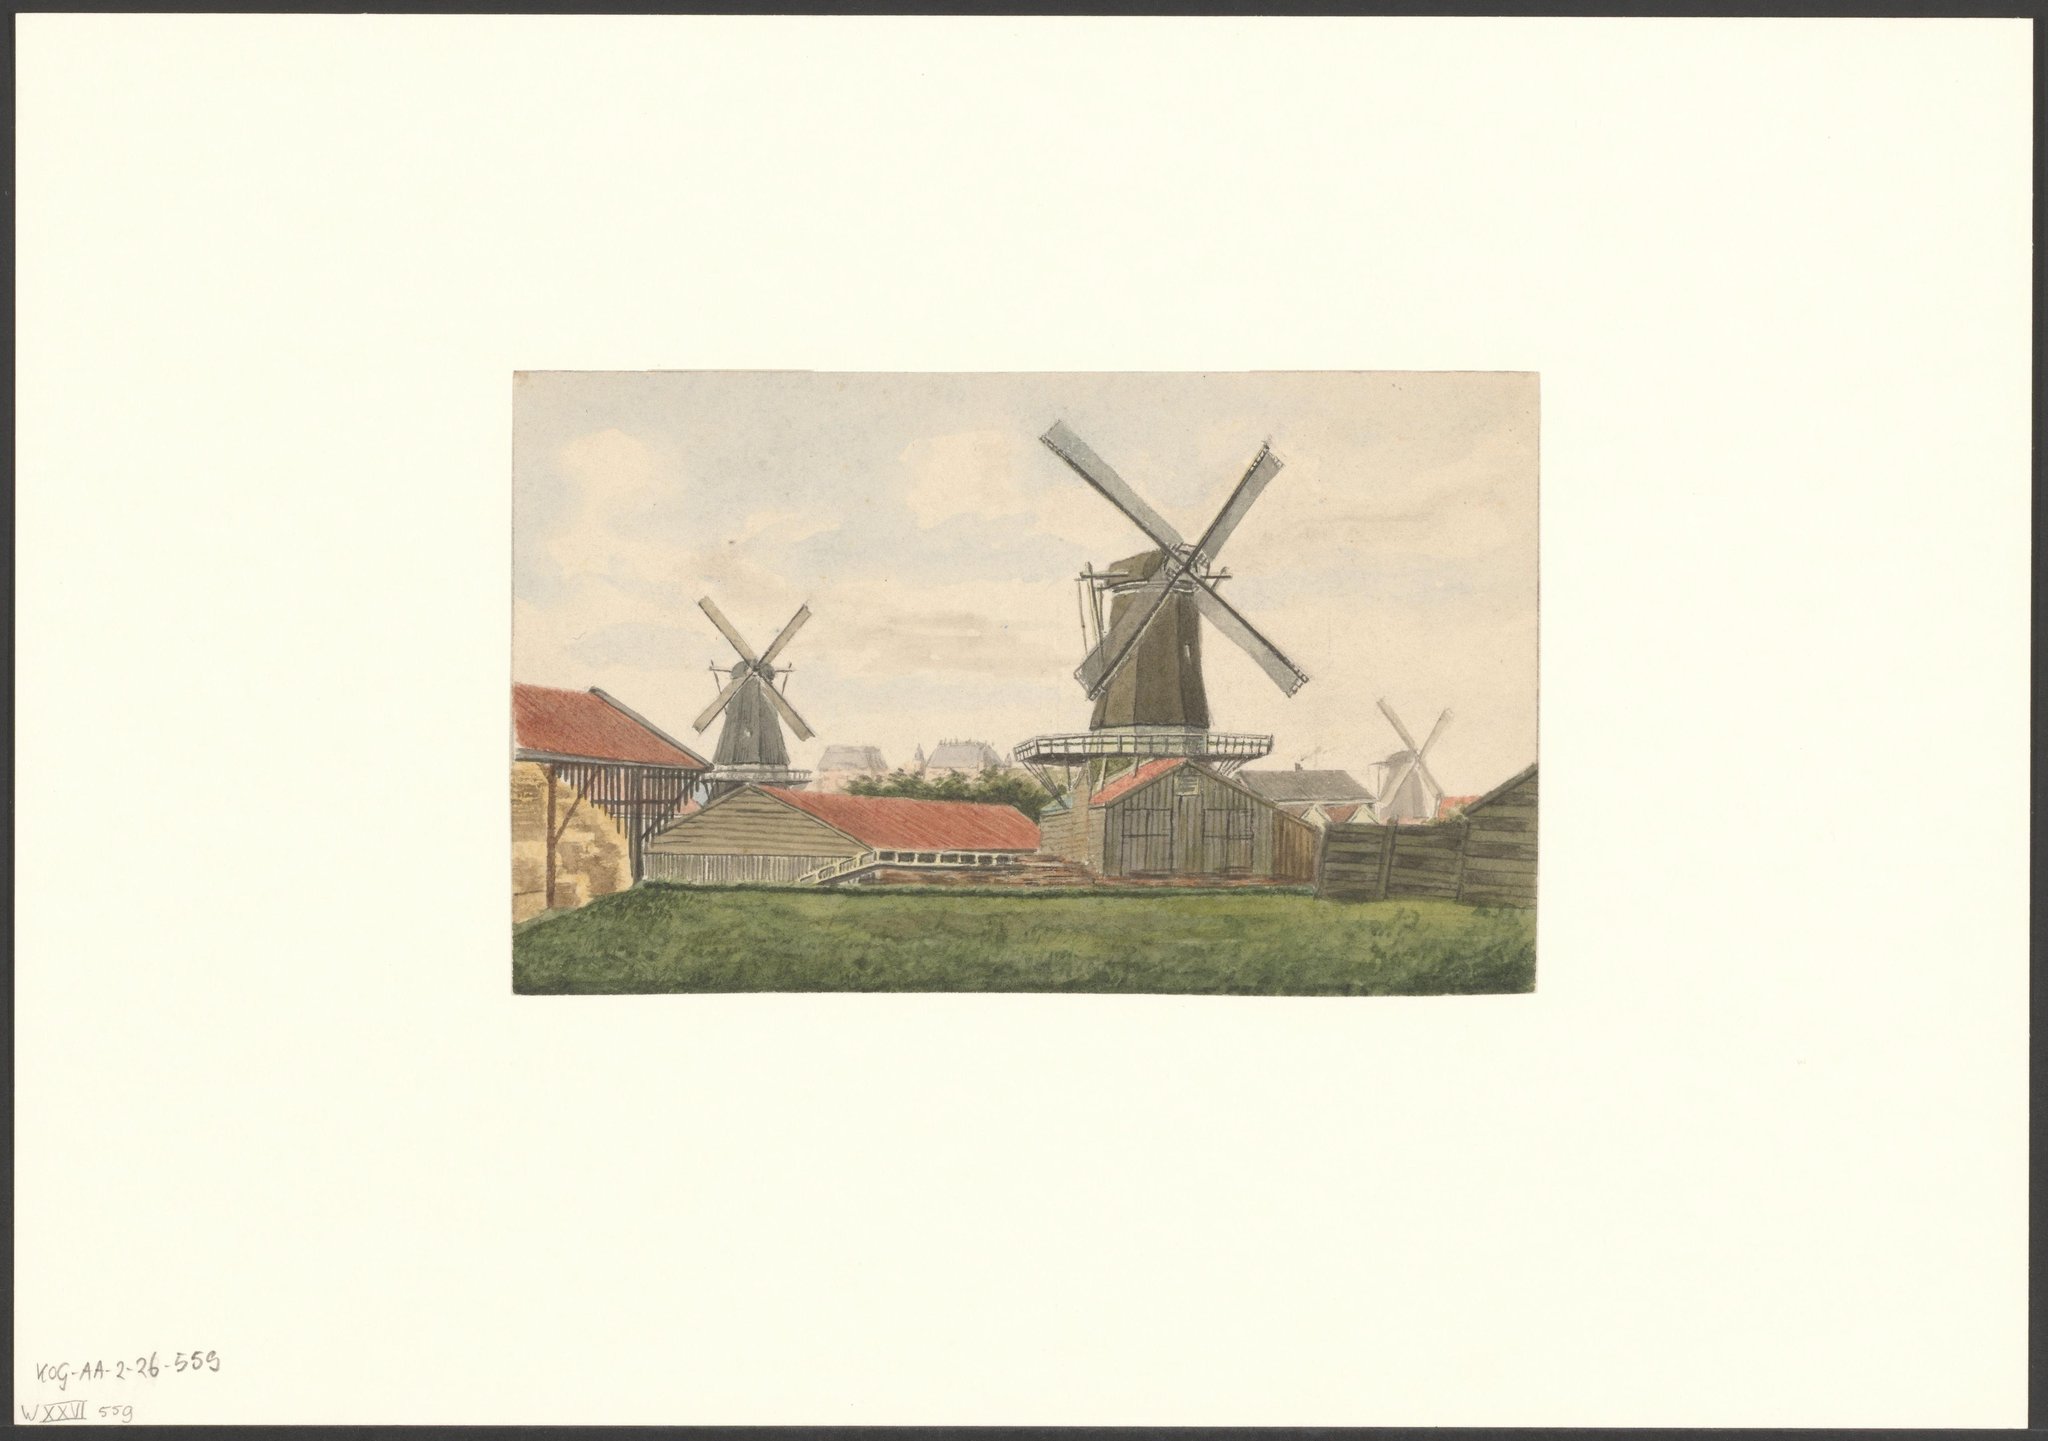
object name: drawing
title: Gezicht op de Zaagmolensloot met molens De Ruiter en Bouwlust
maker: johan george lodewijk rieke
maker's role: draughtsman, print maker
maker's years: 1817-1898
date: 1869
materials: gouache, paper, pencil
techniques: brush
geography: amsterdam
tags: city-view in general; 'veduta', windmill in landscape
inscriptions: signature and date: ‘31 Juli 1869 / J G L Rieke’, inscription: ‘de Molens de Ruyter. Bouwlust / en zeskant Buiten de / Utrechtsche Bariëre’, collector's mark: Lugt 800a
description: Tekening binnen de Atlas Van Eck ingedeeld op wijknummer 26.